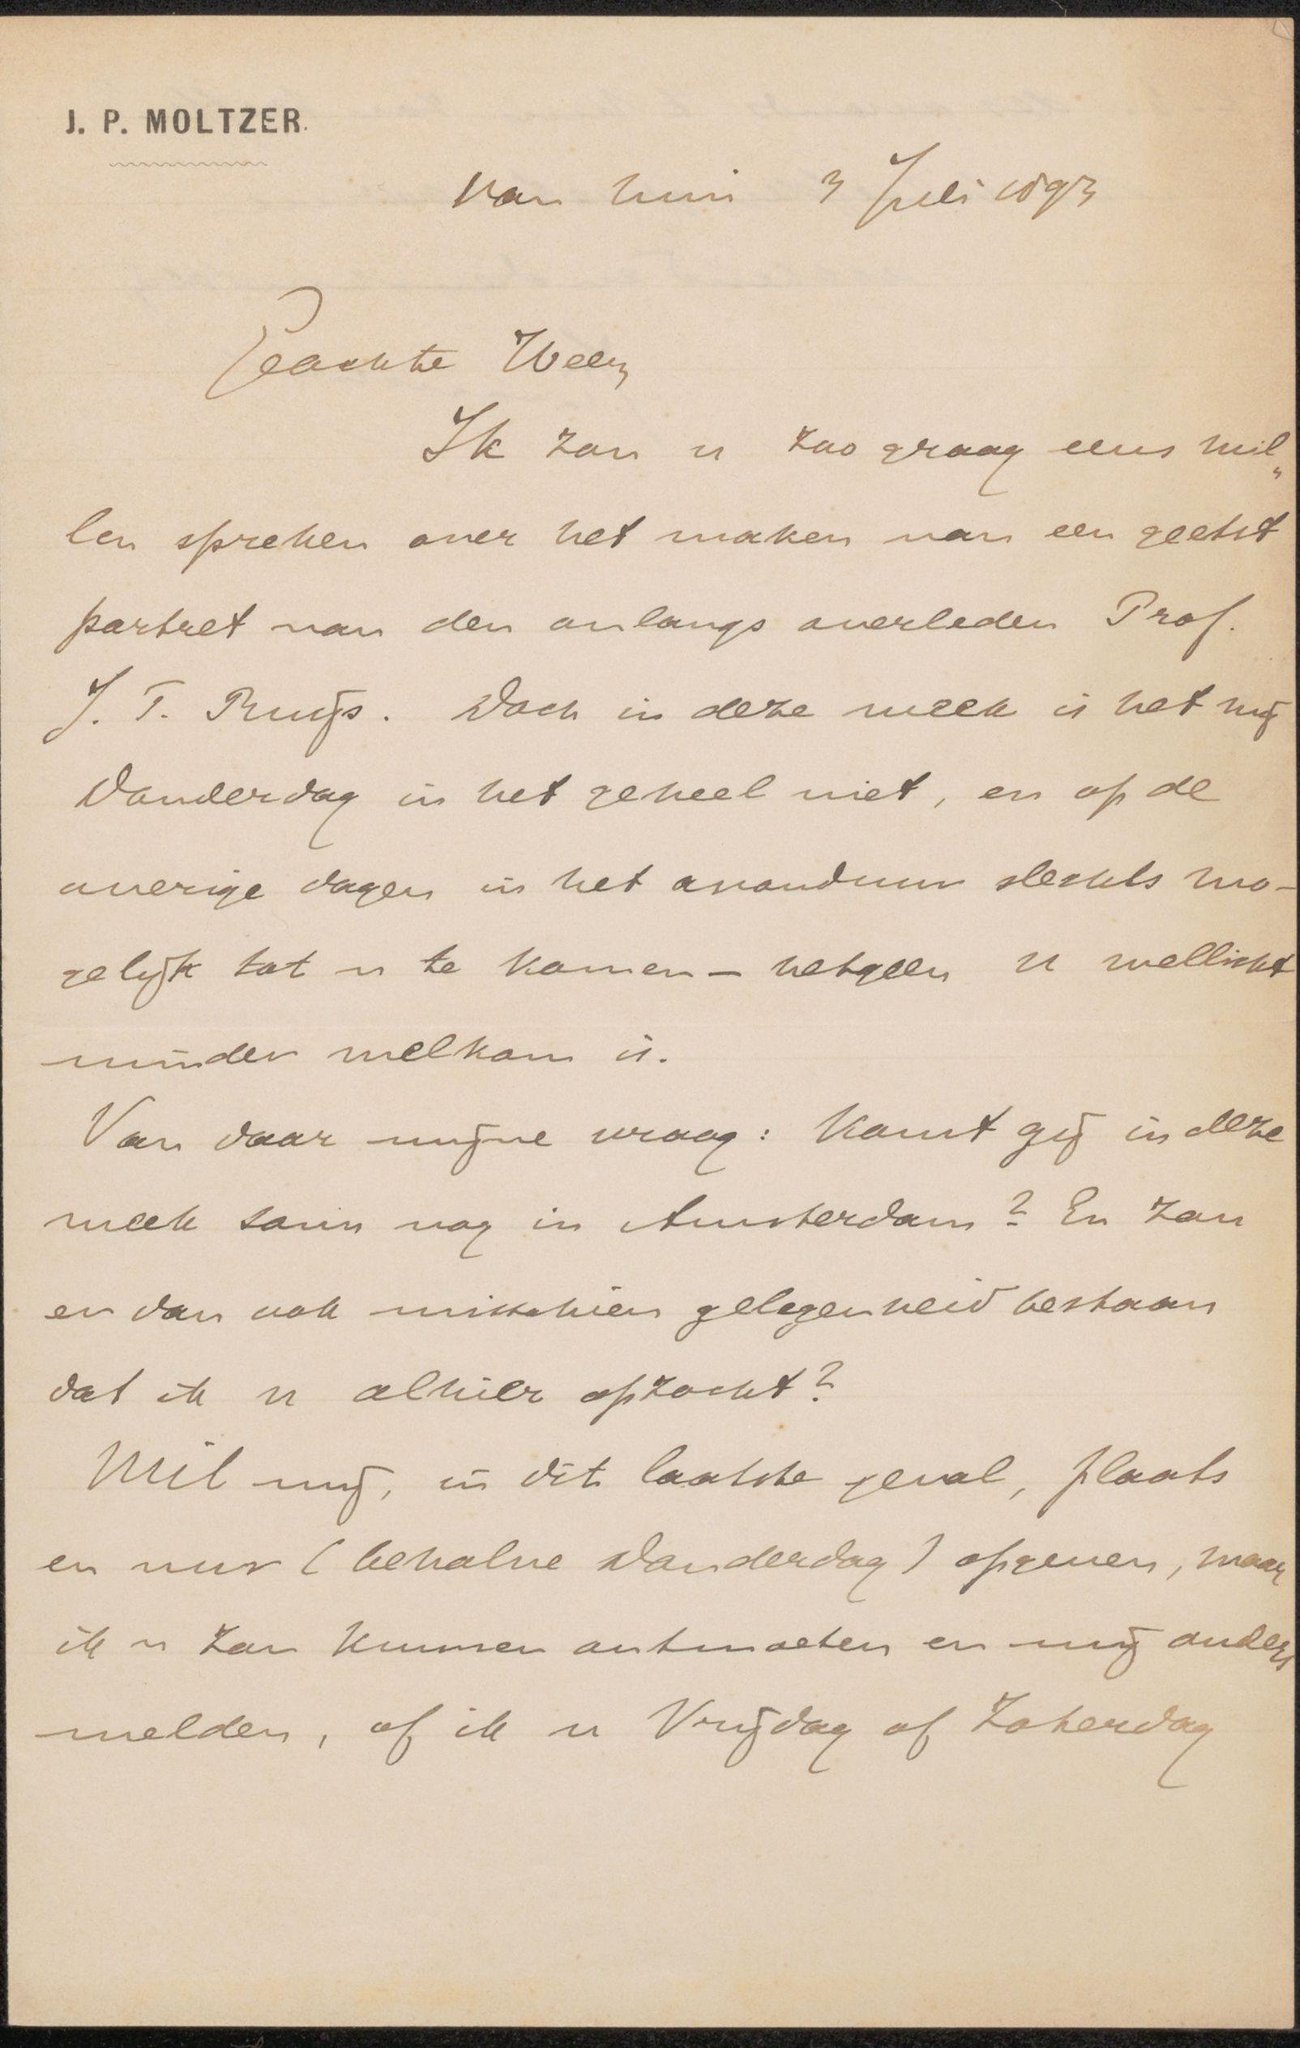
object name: letter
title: Brief aan Jan Veth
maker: jacob pieter moltzer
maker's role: jurist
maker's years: 1850-1907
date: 1893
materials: ink, paper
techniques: pen, writing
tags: painter, draughtsman, designer, jan veth, amsterdam, warmond, the graphic arts, historical persons (portraits and scenes from the life)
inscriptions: collector's mark: ‘RPK’, name: ‘J.P. MOLTZER.’